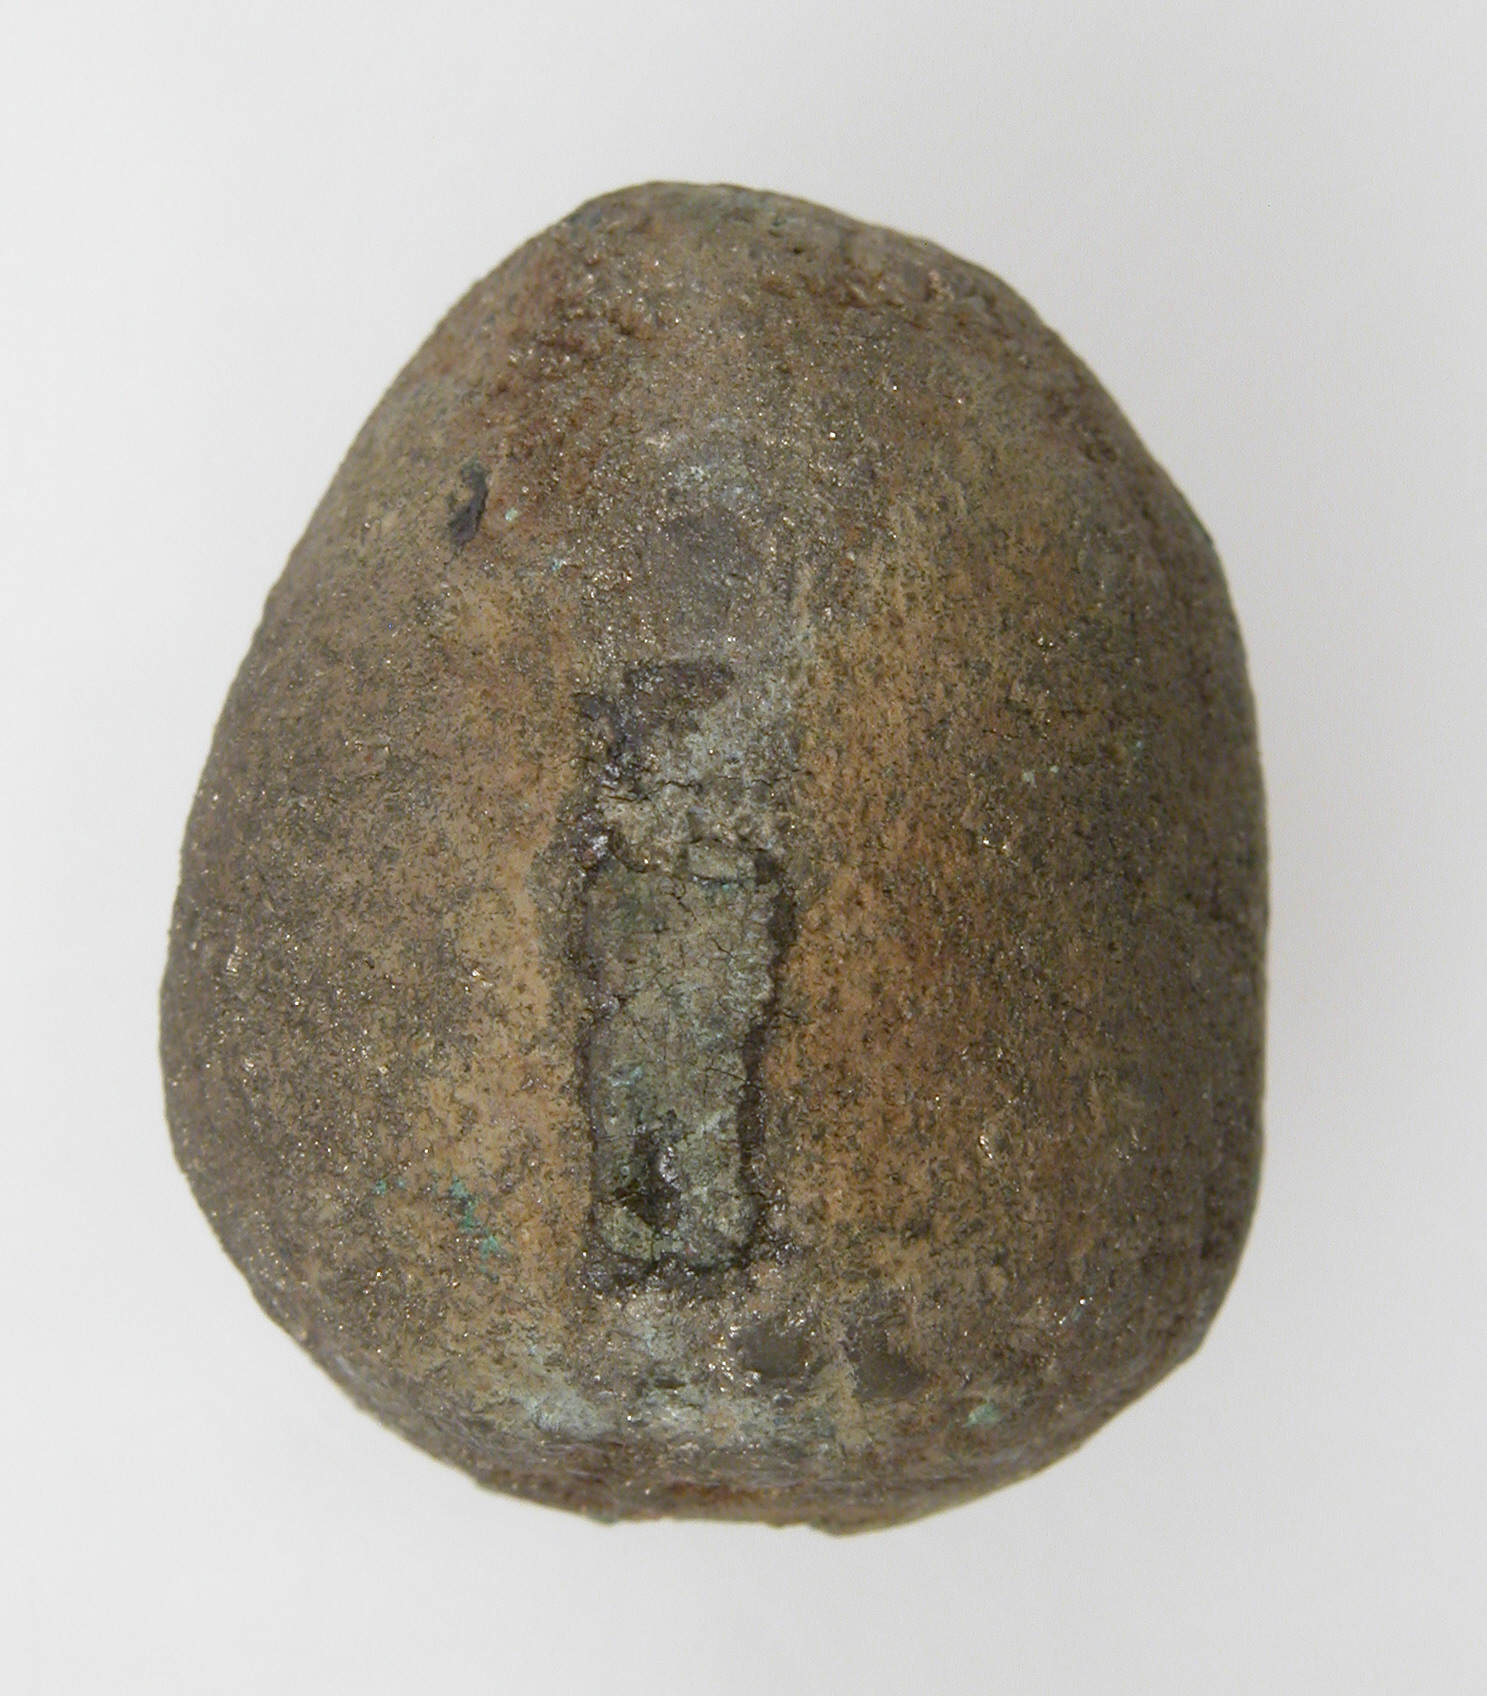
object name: pendant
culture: frankish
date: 501-700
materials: bronze